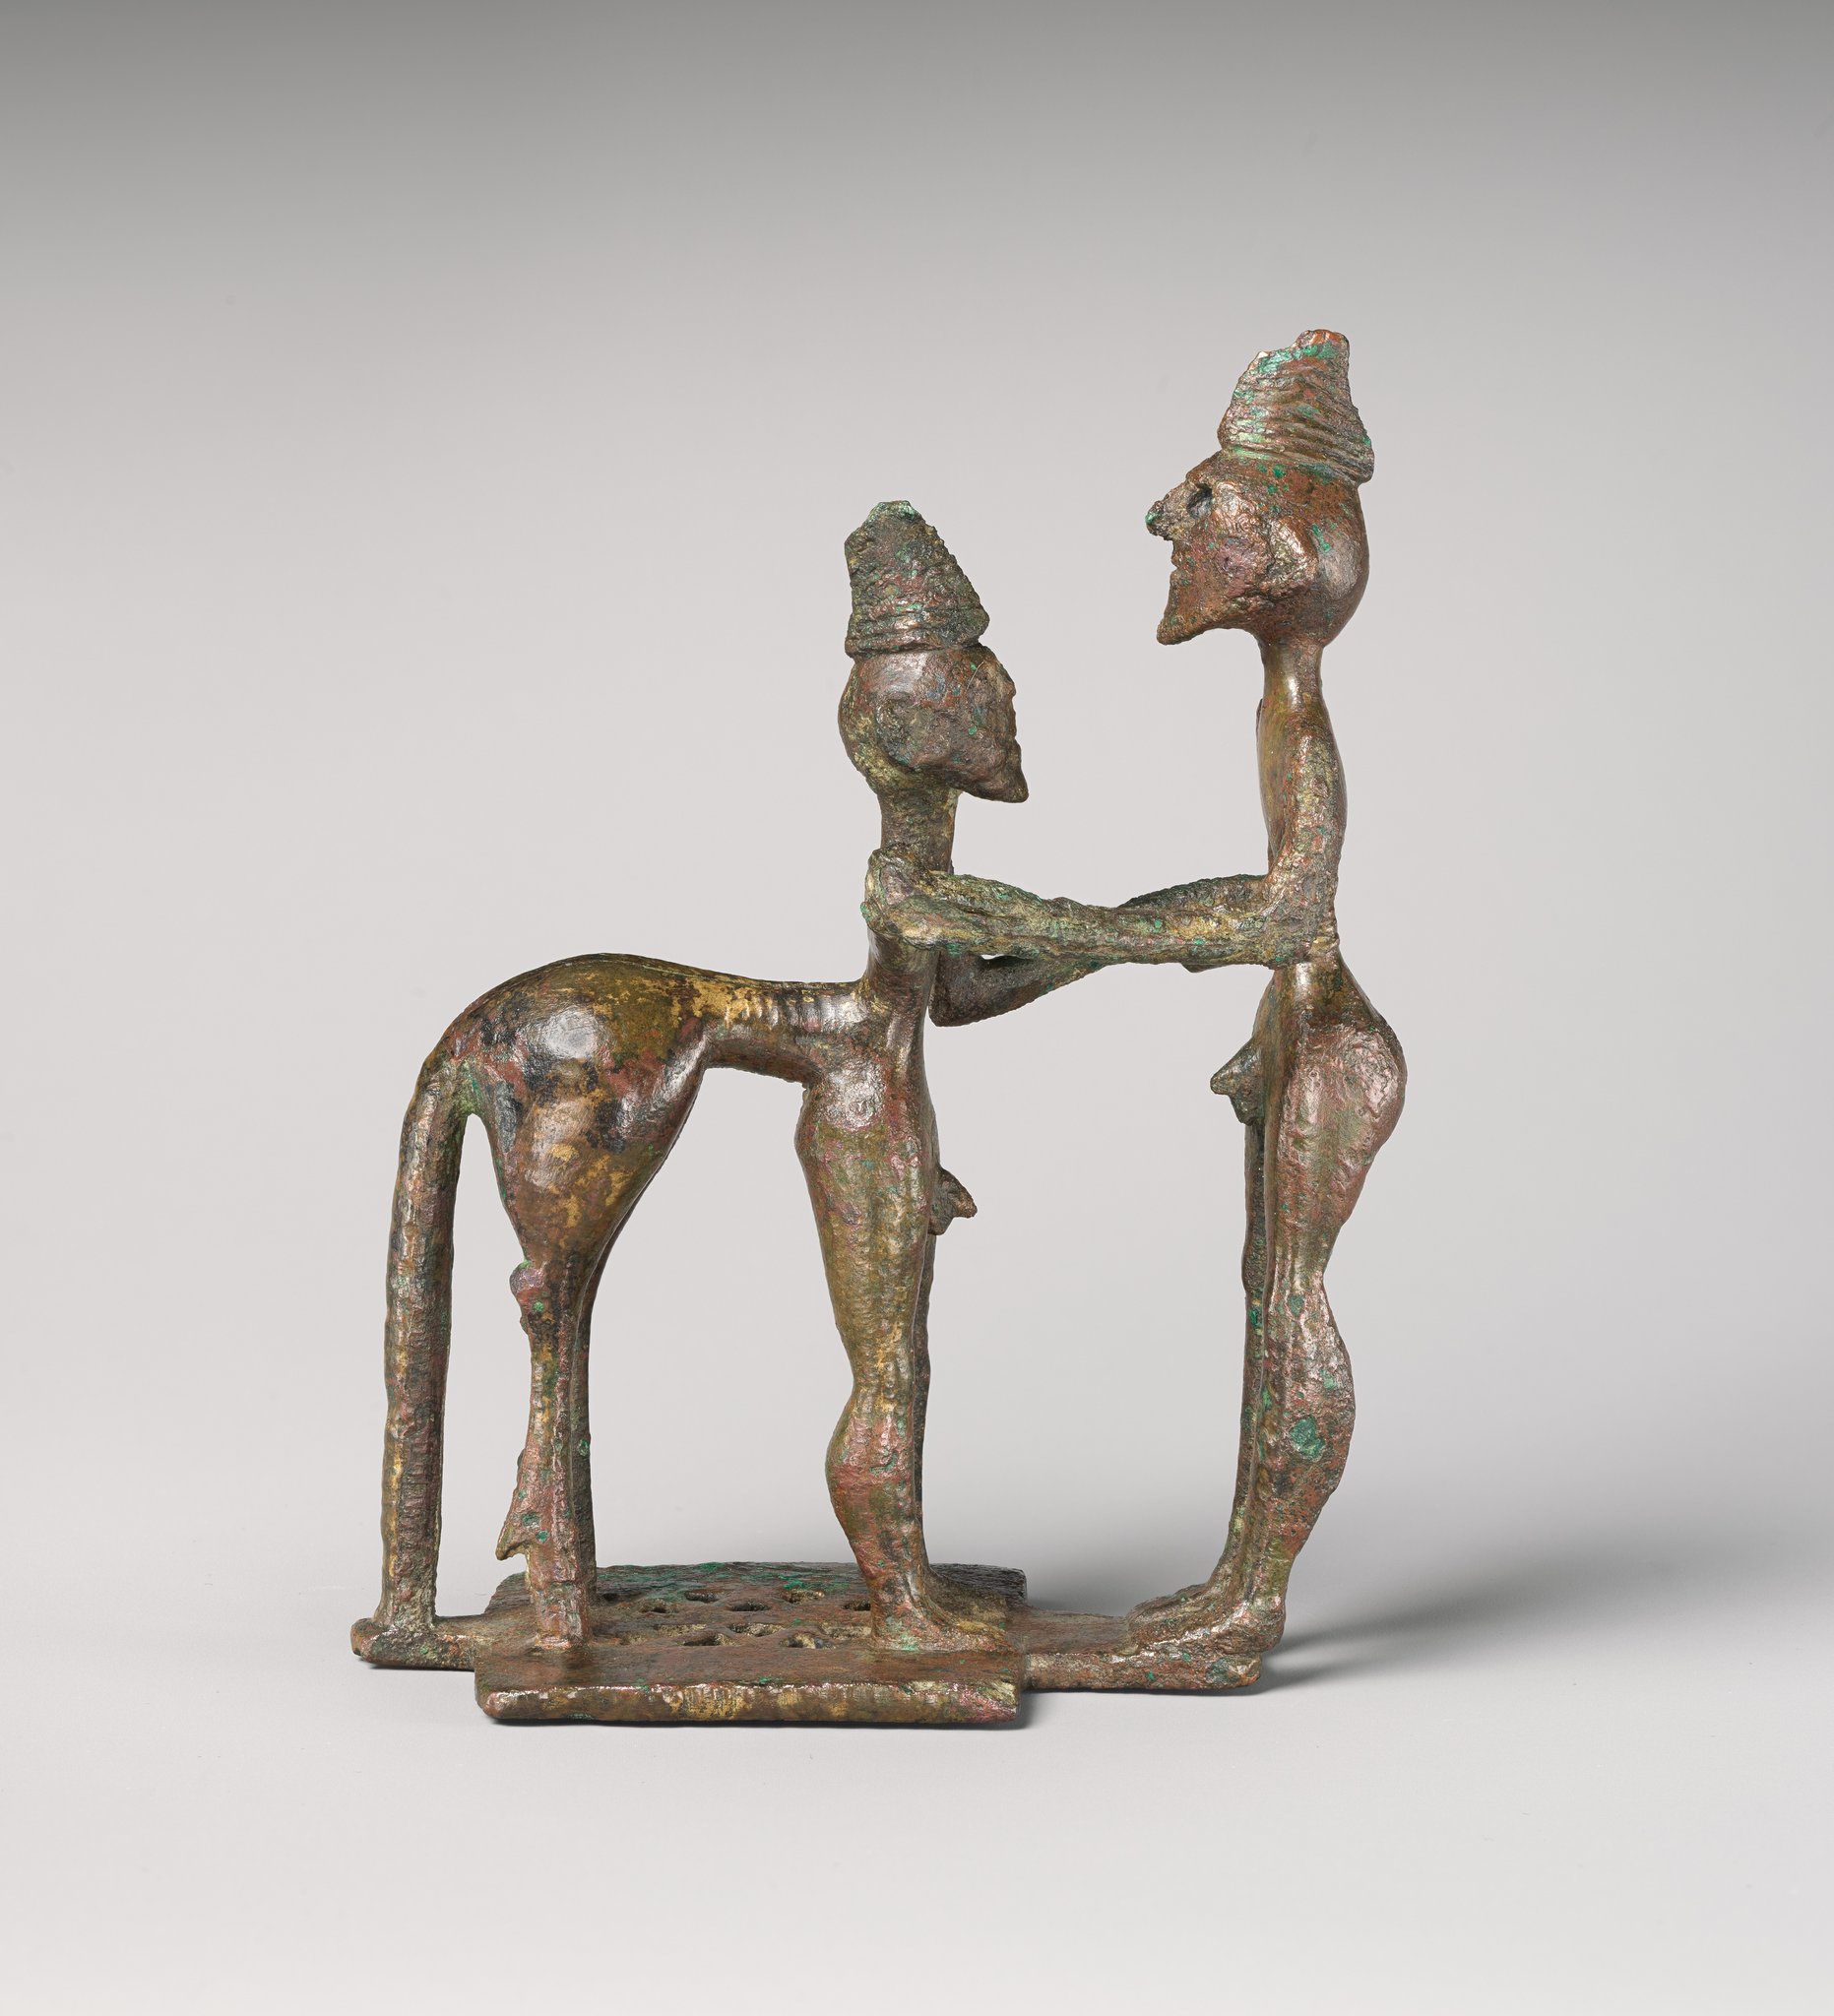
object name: statuette of a centaur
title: Bronze man and centaur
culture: greek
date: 750 BCE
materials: bronze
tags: men,centaurs